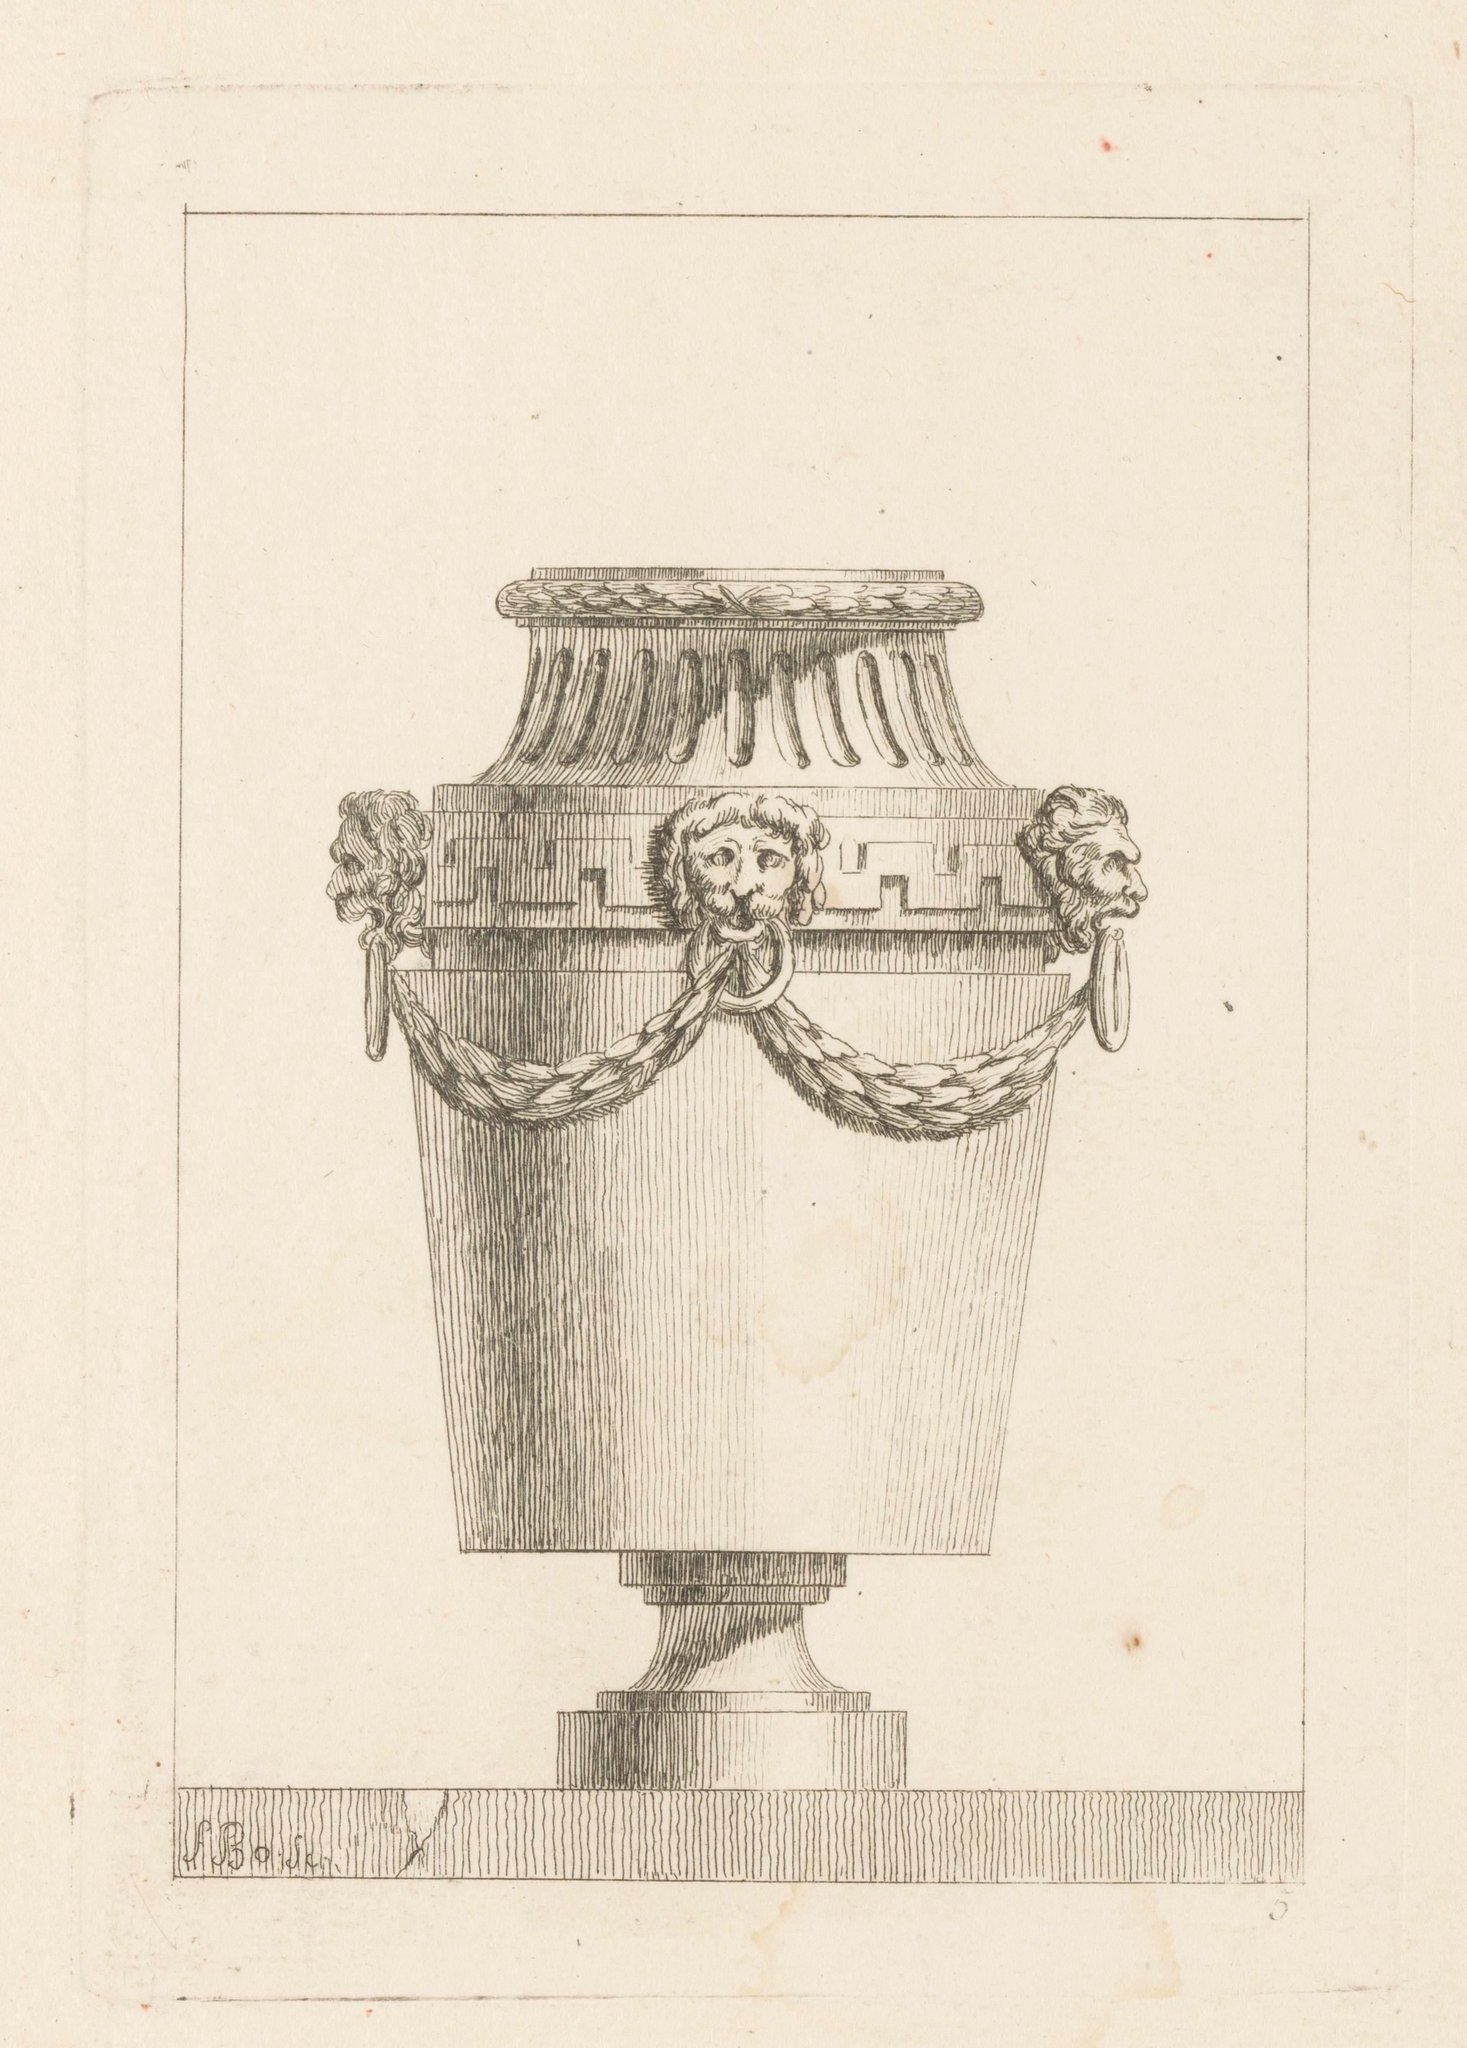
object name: ornament print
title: Nouveau Livre de Vases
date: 1755-1782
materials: paper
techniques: etching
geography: paris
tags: vase ~ ornament, ornament ~ festoon, garland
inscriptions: collector's mark: Lugt 2228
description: Een vaas met guirlandes op de buik en twee handvaten.